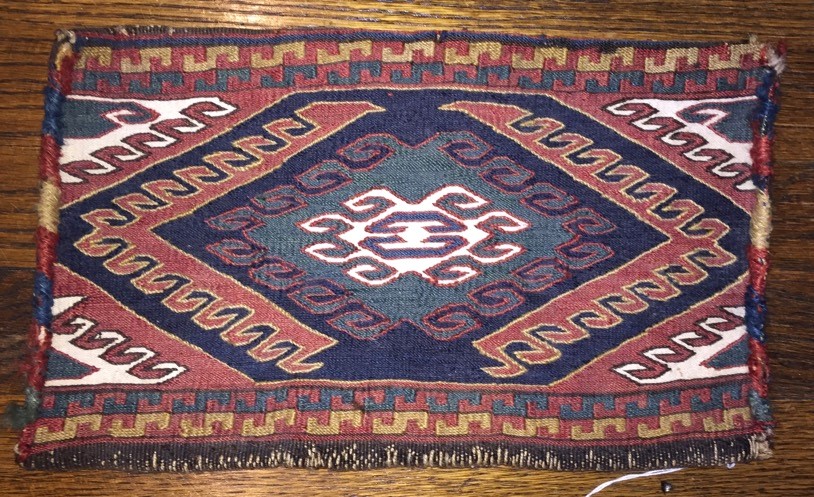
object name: saddle bag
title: Qarabagh Small Bag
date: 1880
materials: cotton, wool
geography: iran